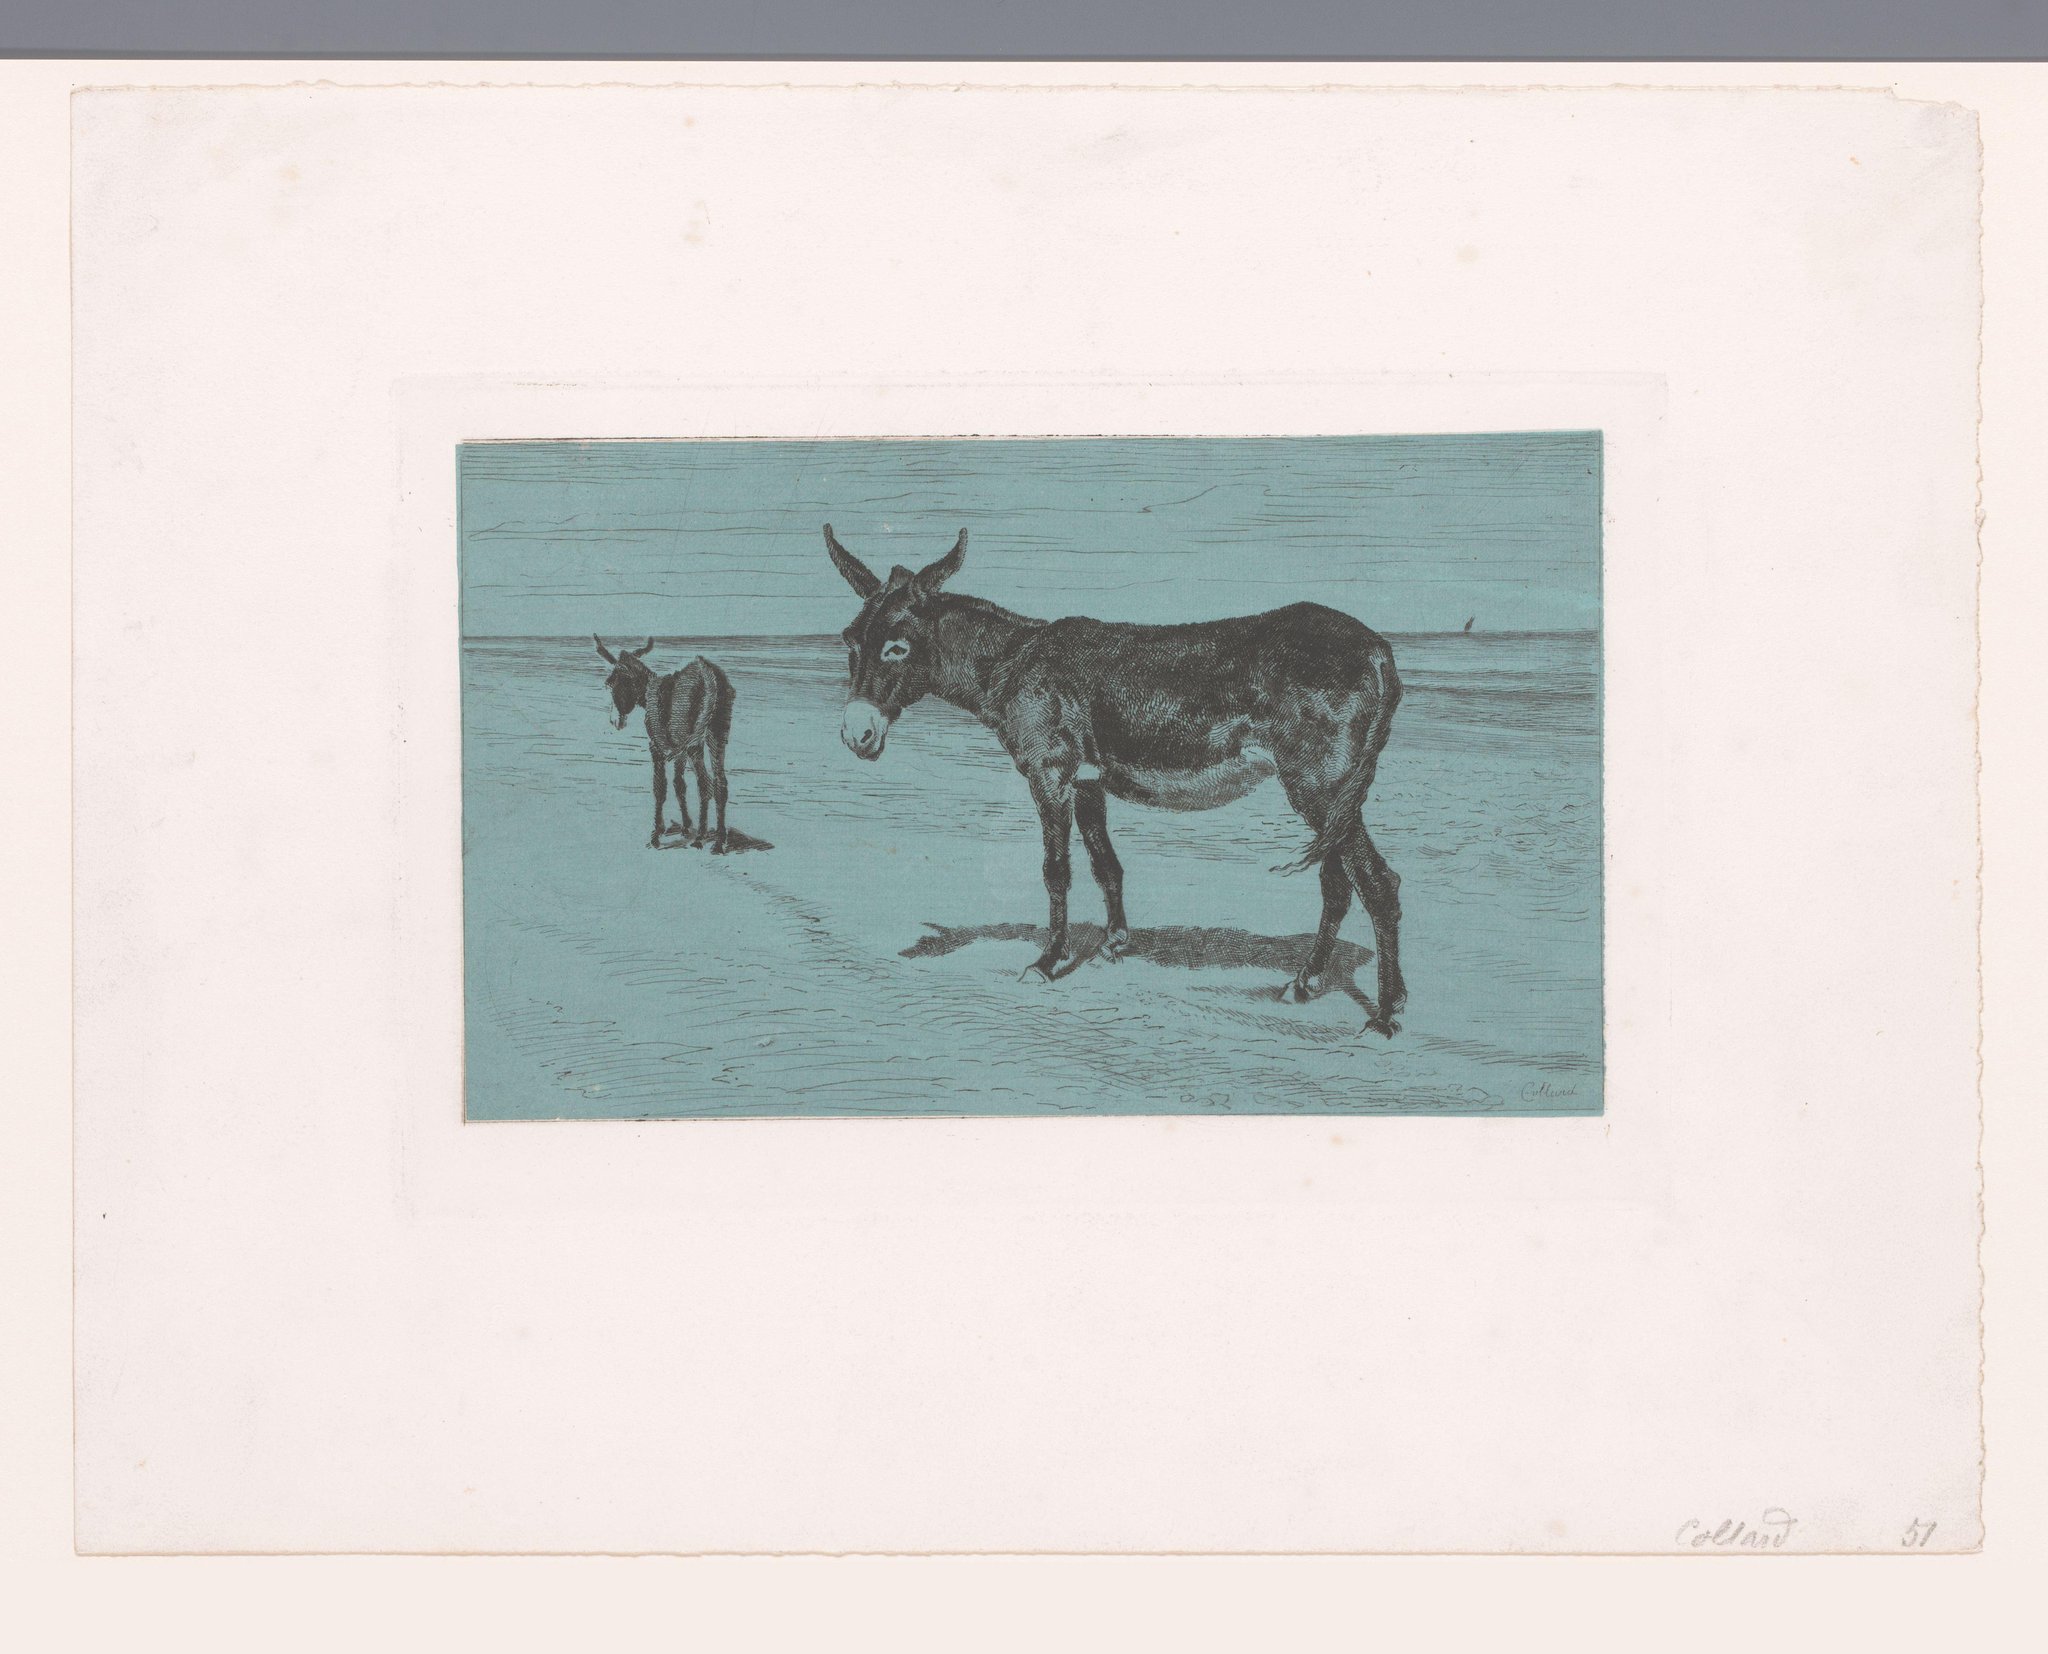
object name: print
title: Twee ezels op het strand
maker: armand collard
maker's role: print maker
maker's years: 1838-1910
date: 1848-1909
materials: paper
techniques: etching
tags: ass, donkey, beach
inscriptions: collector's mark: Lugt 2228